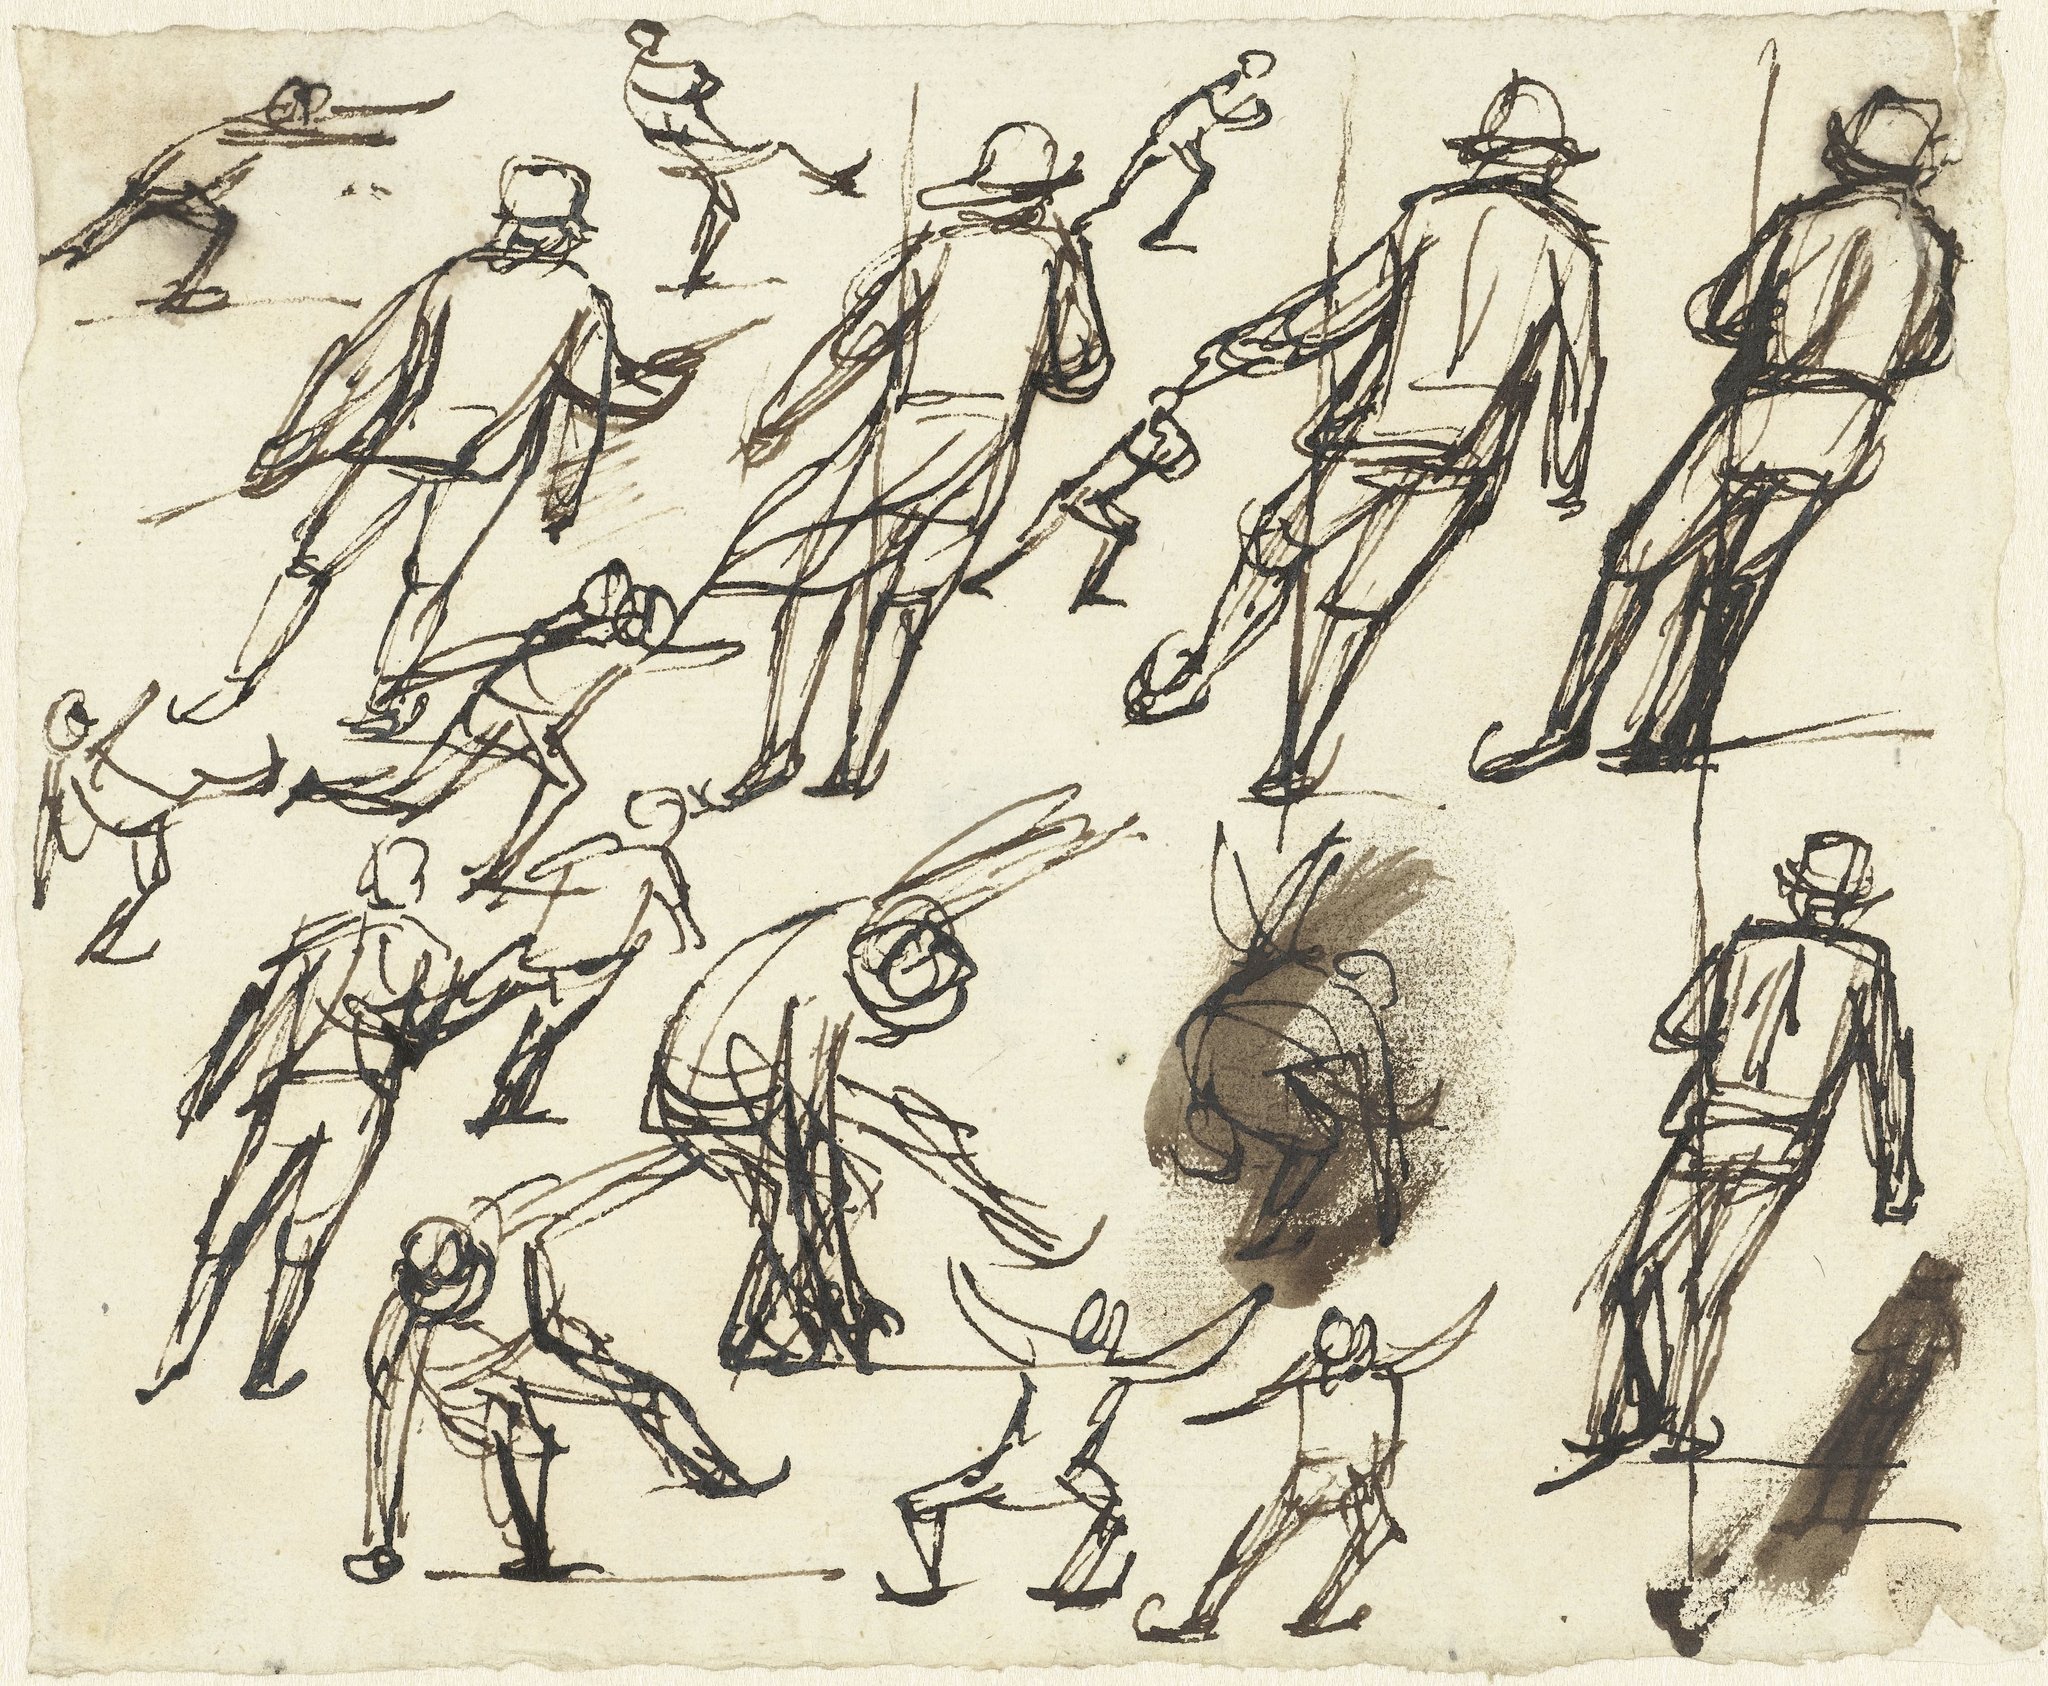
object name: drawing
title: Studieblad met schaatsenrijders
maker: simon andreas krausz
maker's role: draughtsman, print maker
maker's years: 1760-1825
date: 1770-1825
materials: ink, paper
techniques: pen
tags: skates (winter sports)